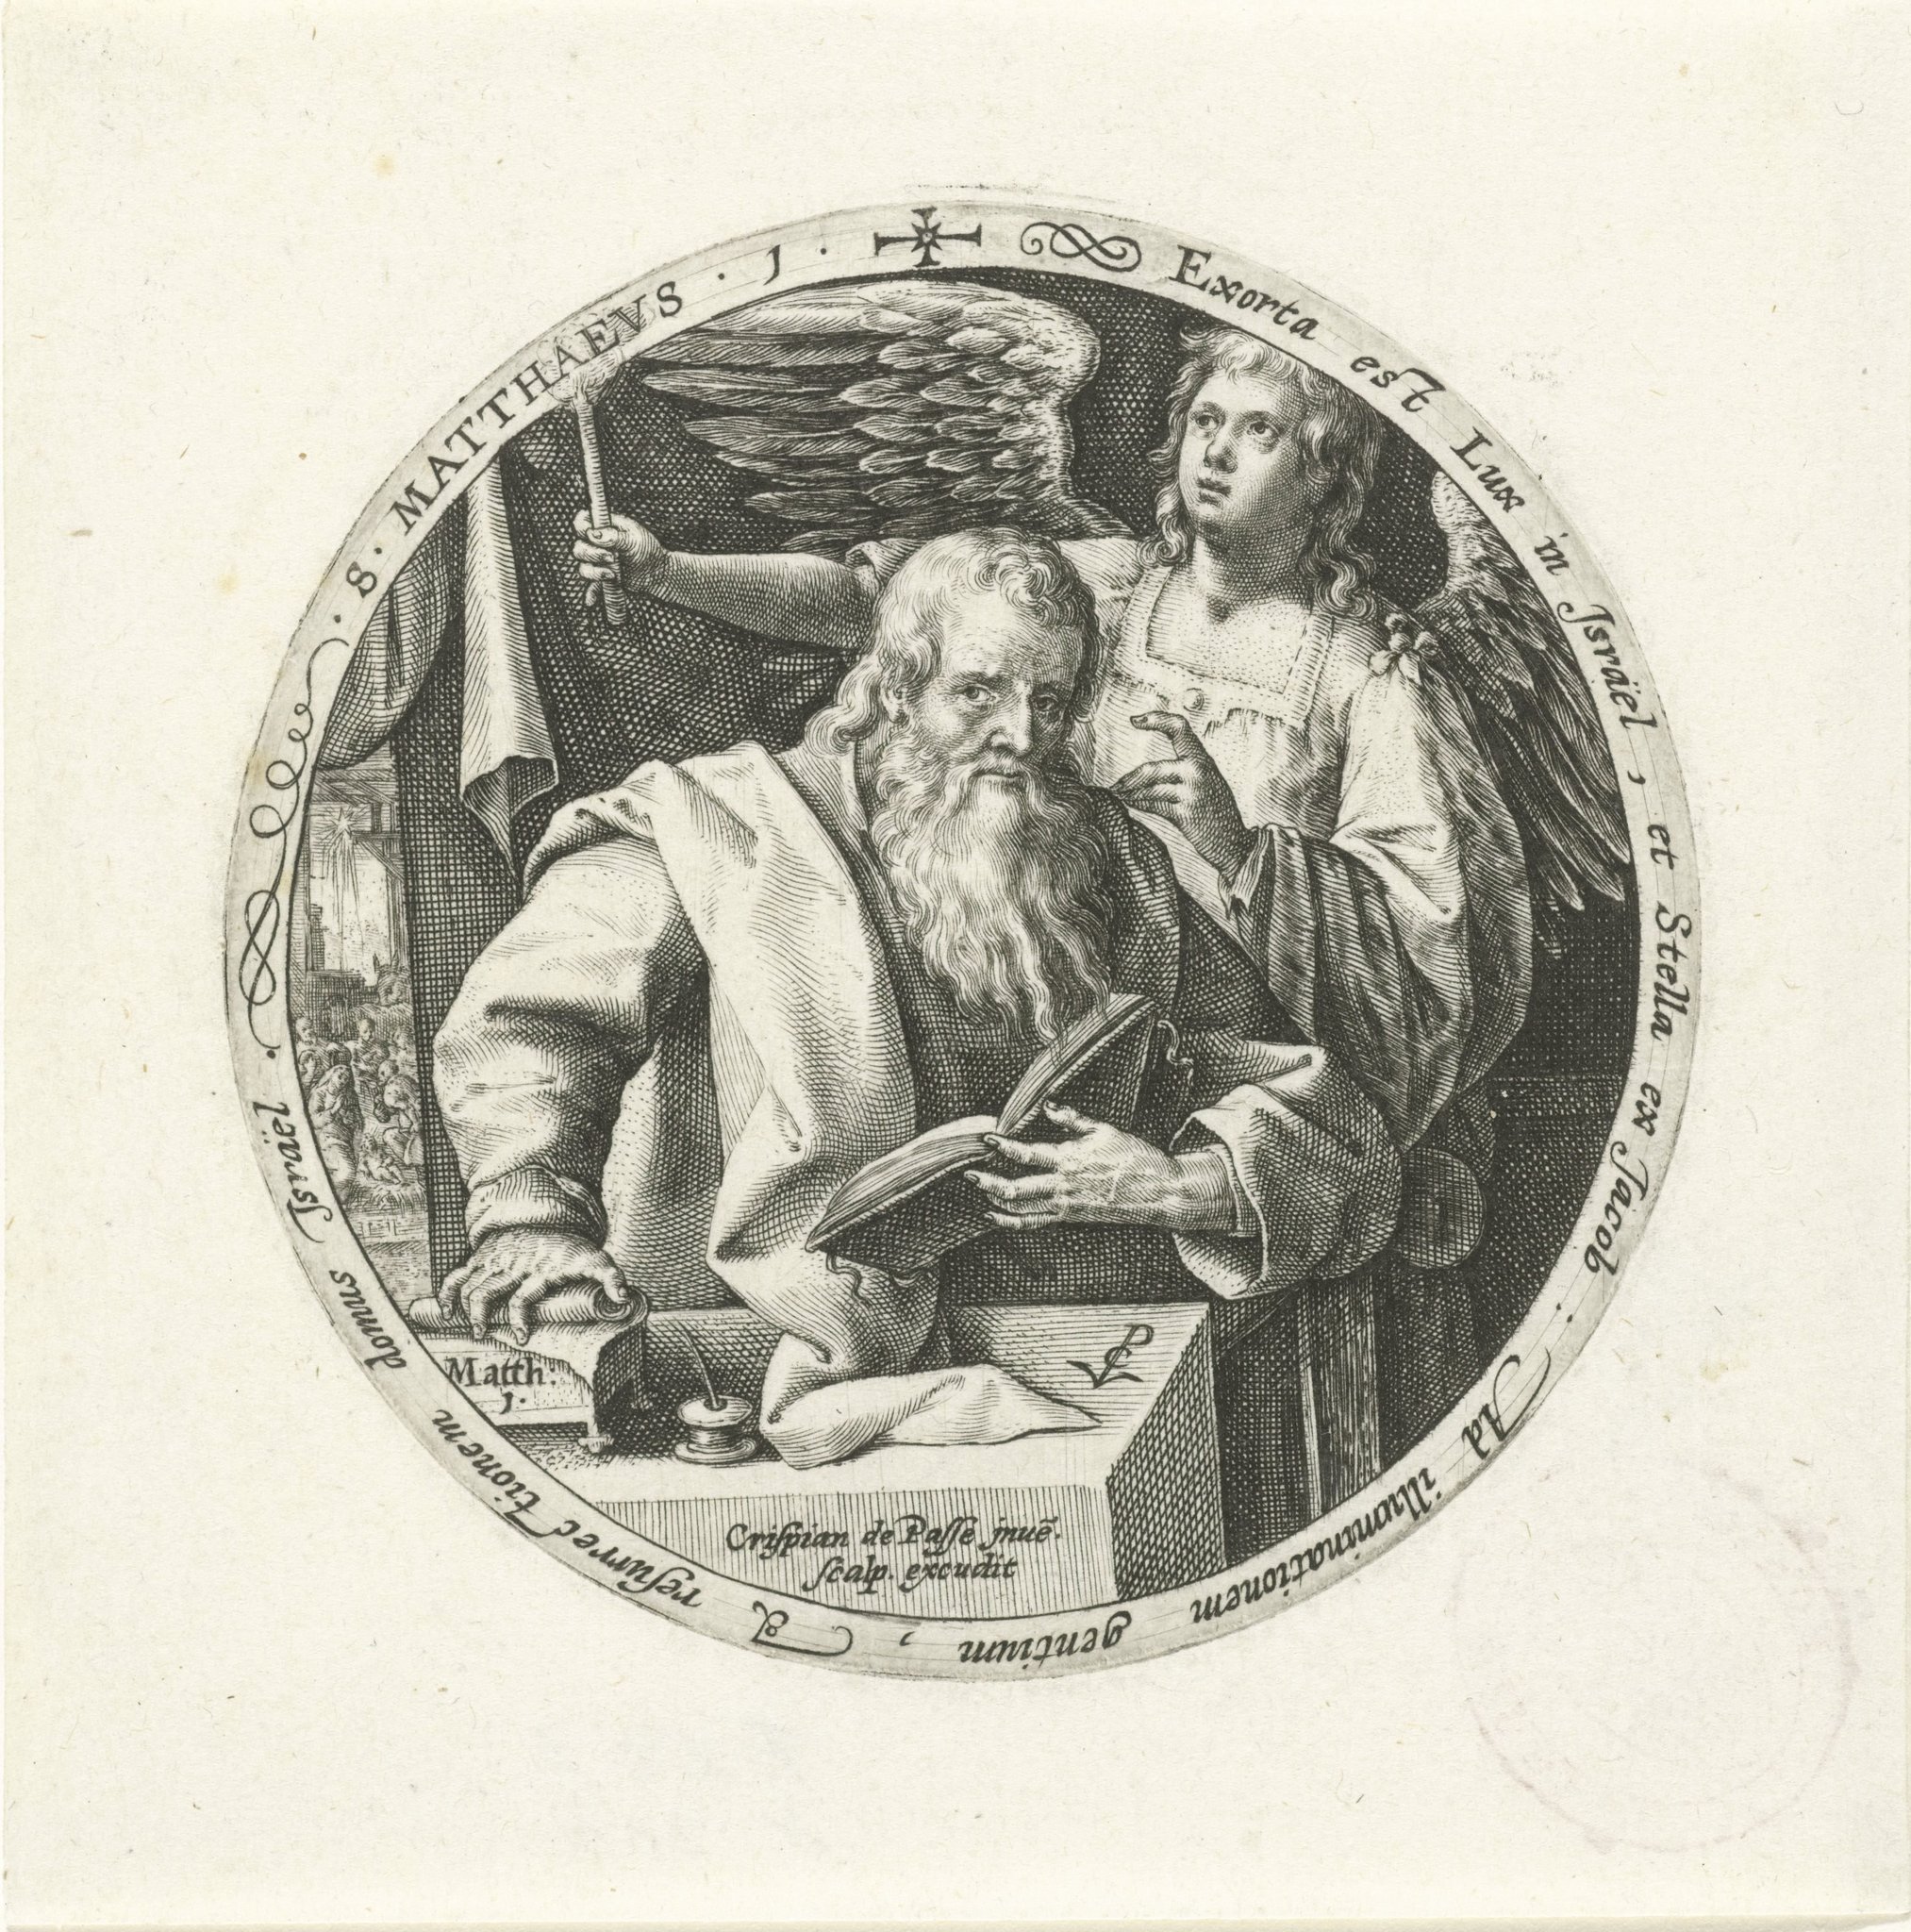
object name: print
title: De evangelist Matteüs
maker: crispijn van de passe (i)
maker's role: draughtsman, print maker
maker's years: 1564-1637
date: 1574-1637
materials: paper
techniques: engraving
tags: adoration of the christ-child ~ christ's birth, st. matthew writing the gospel, usually the angel present, dictating or assisting him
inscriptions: collector's mark: Lugt 240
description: De evangelist Matteüs die zijn evangelie schrijft. Achter hem zijn attribuut de engel met een brandende fakkel. Op de achtergrond de aanbidding van het Christuskind in de stal. De voorstelling is gevat in een ronde omlijsting met een randschrift in het Latijn. Prent uit een serie van vier met de evangelisten.